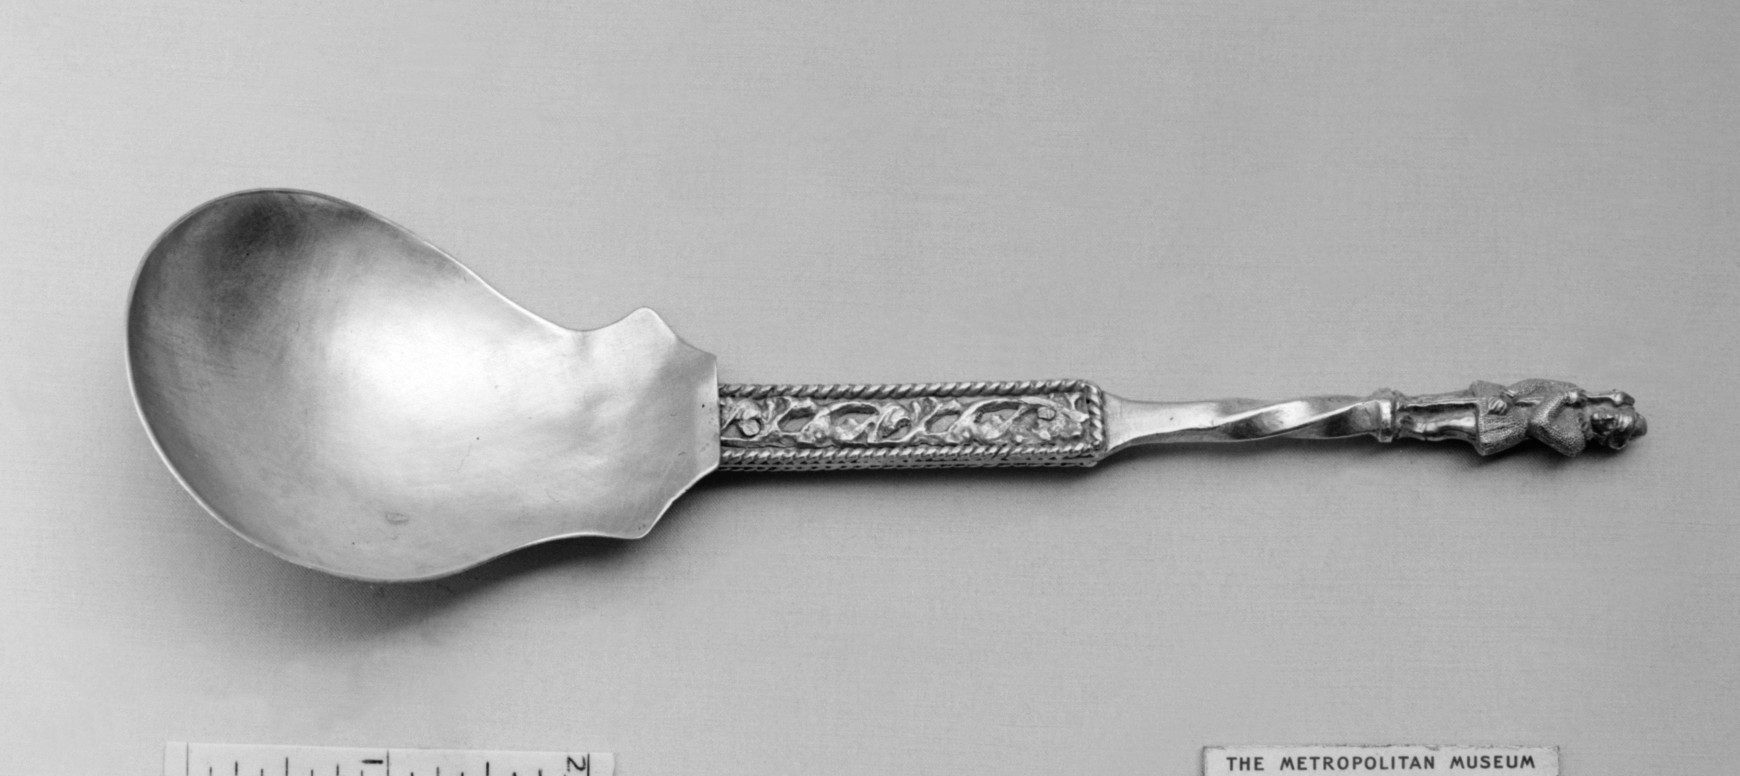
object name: spoon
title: Figure-top spoon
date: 1801-1900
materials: silver gilt